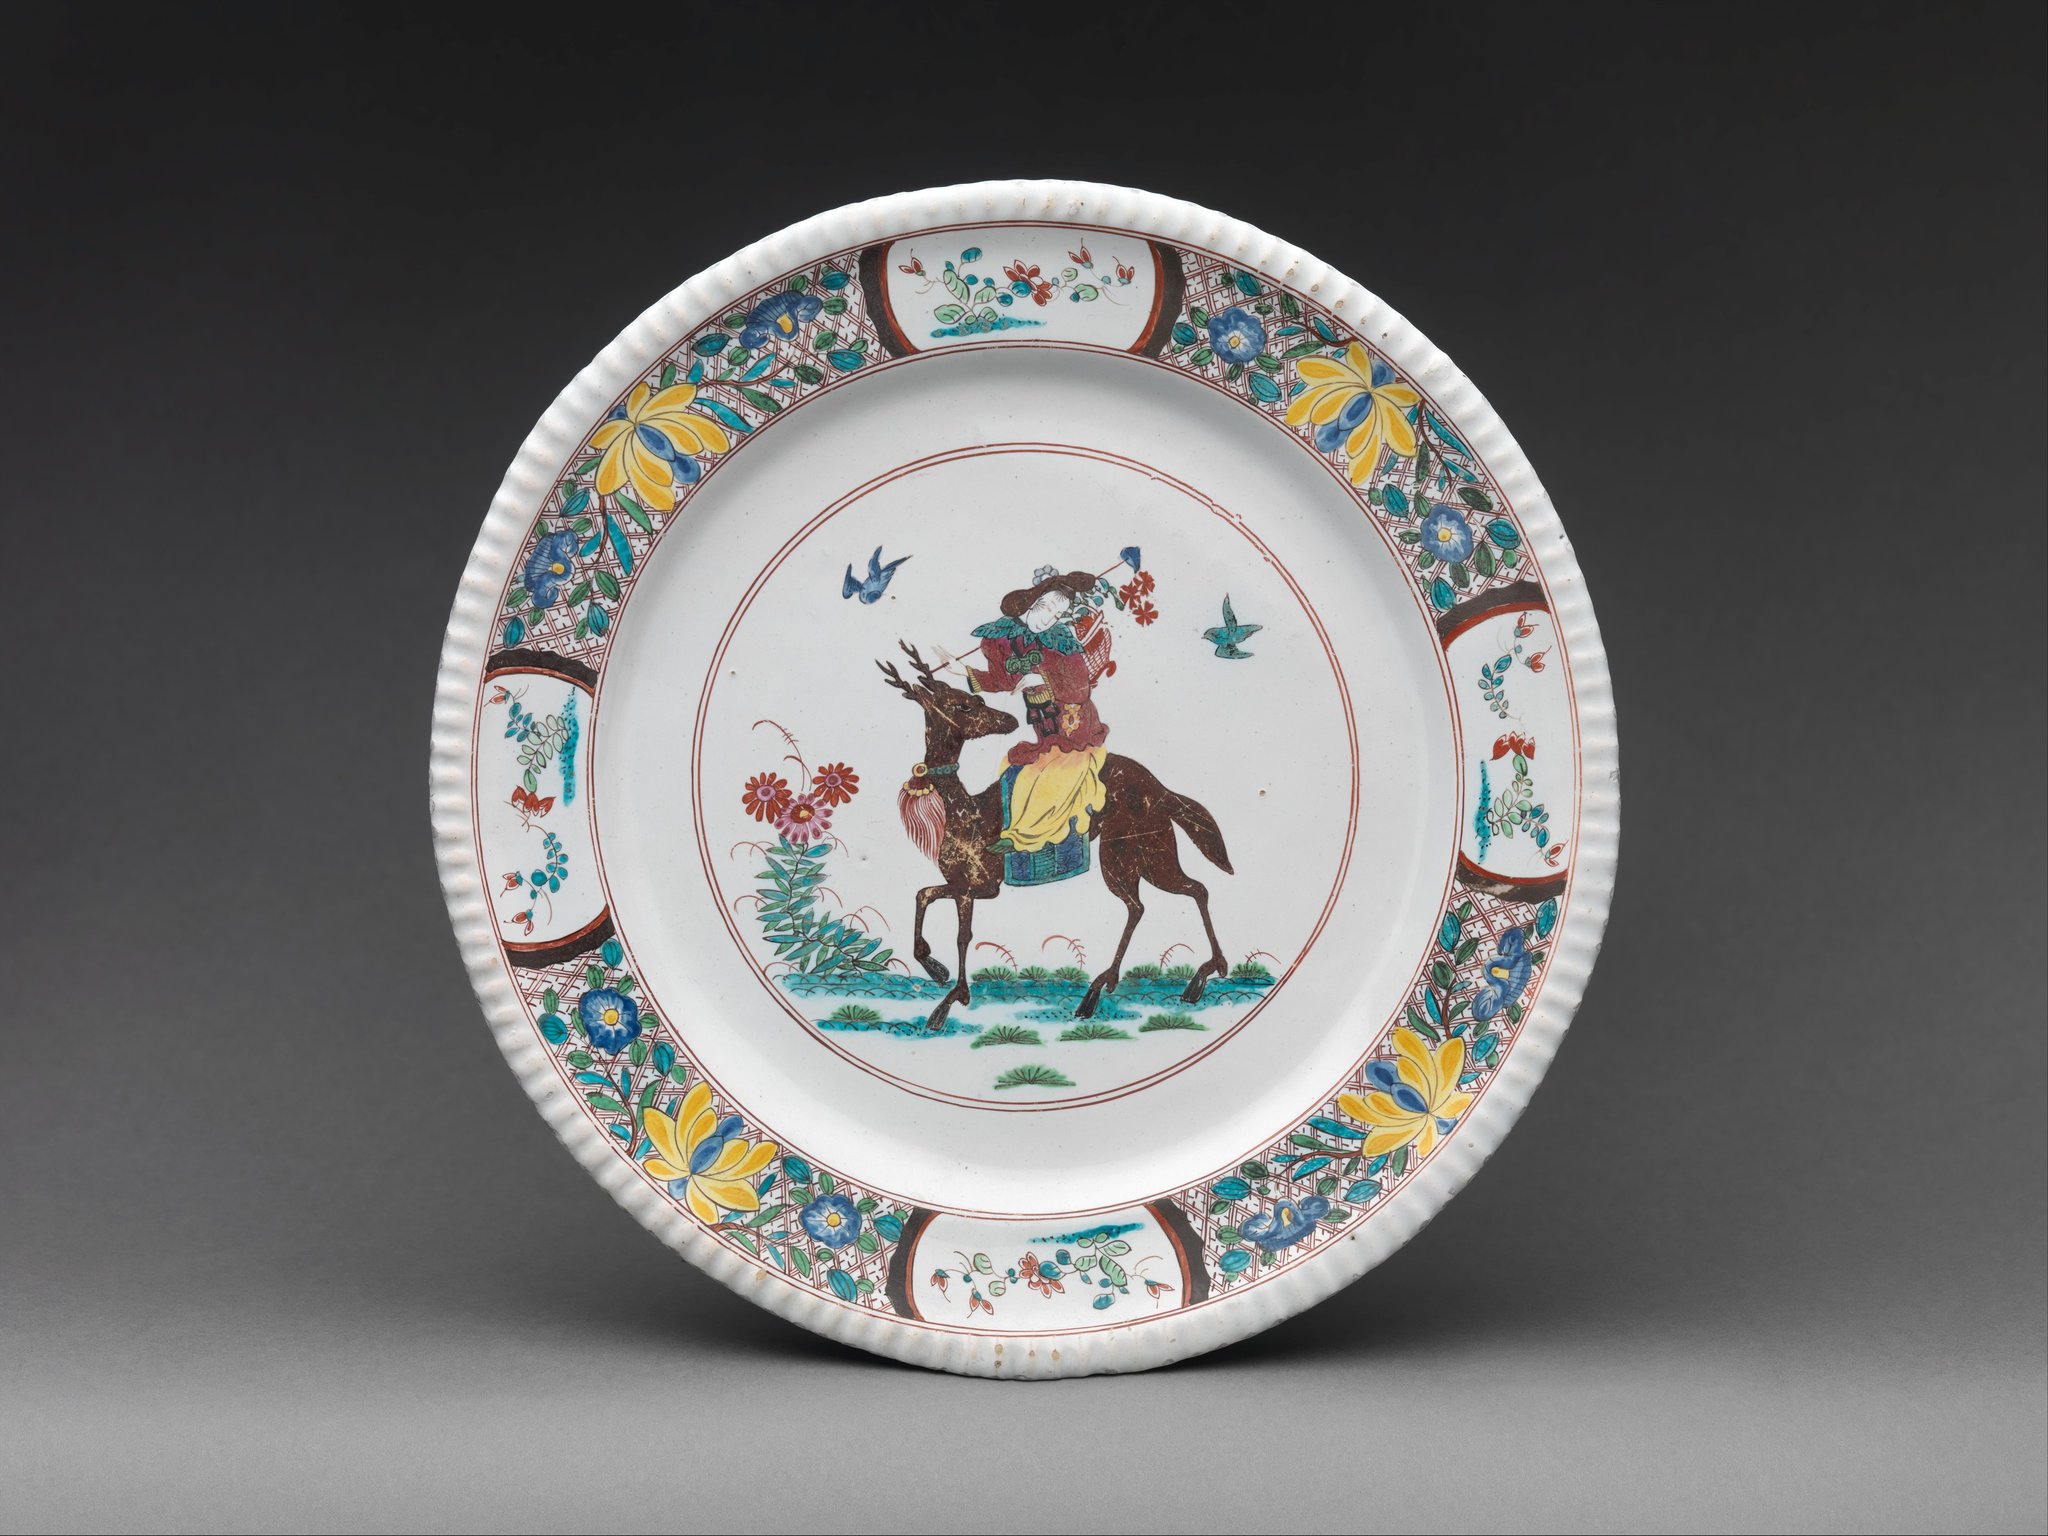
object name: plate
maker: adam friedrich von löwenfinck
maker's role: decorator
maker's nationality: german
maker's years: 1714-1754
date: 1741-1744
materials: earthenware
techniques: glazing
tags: animals